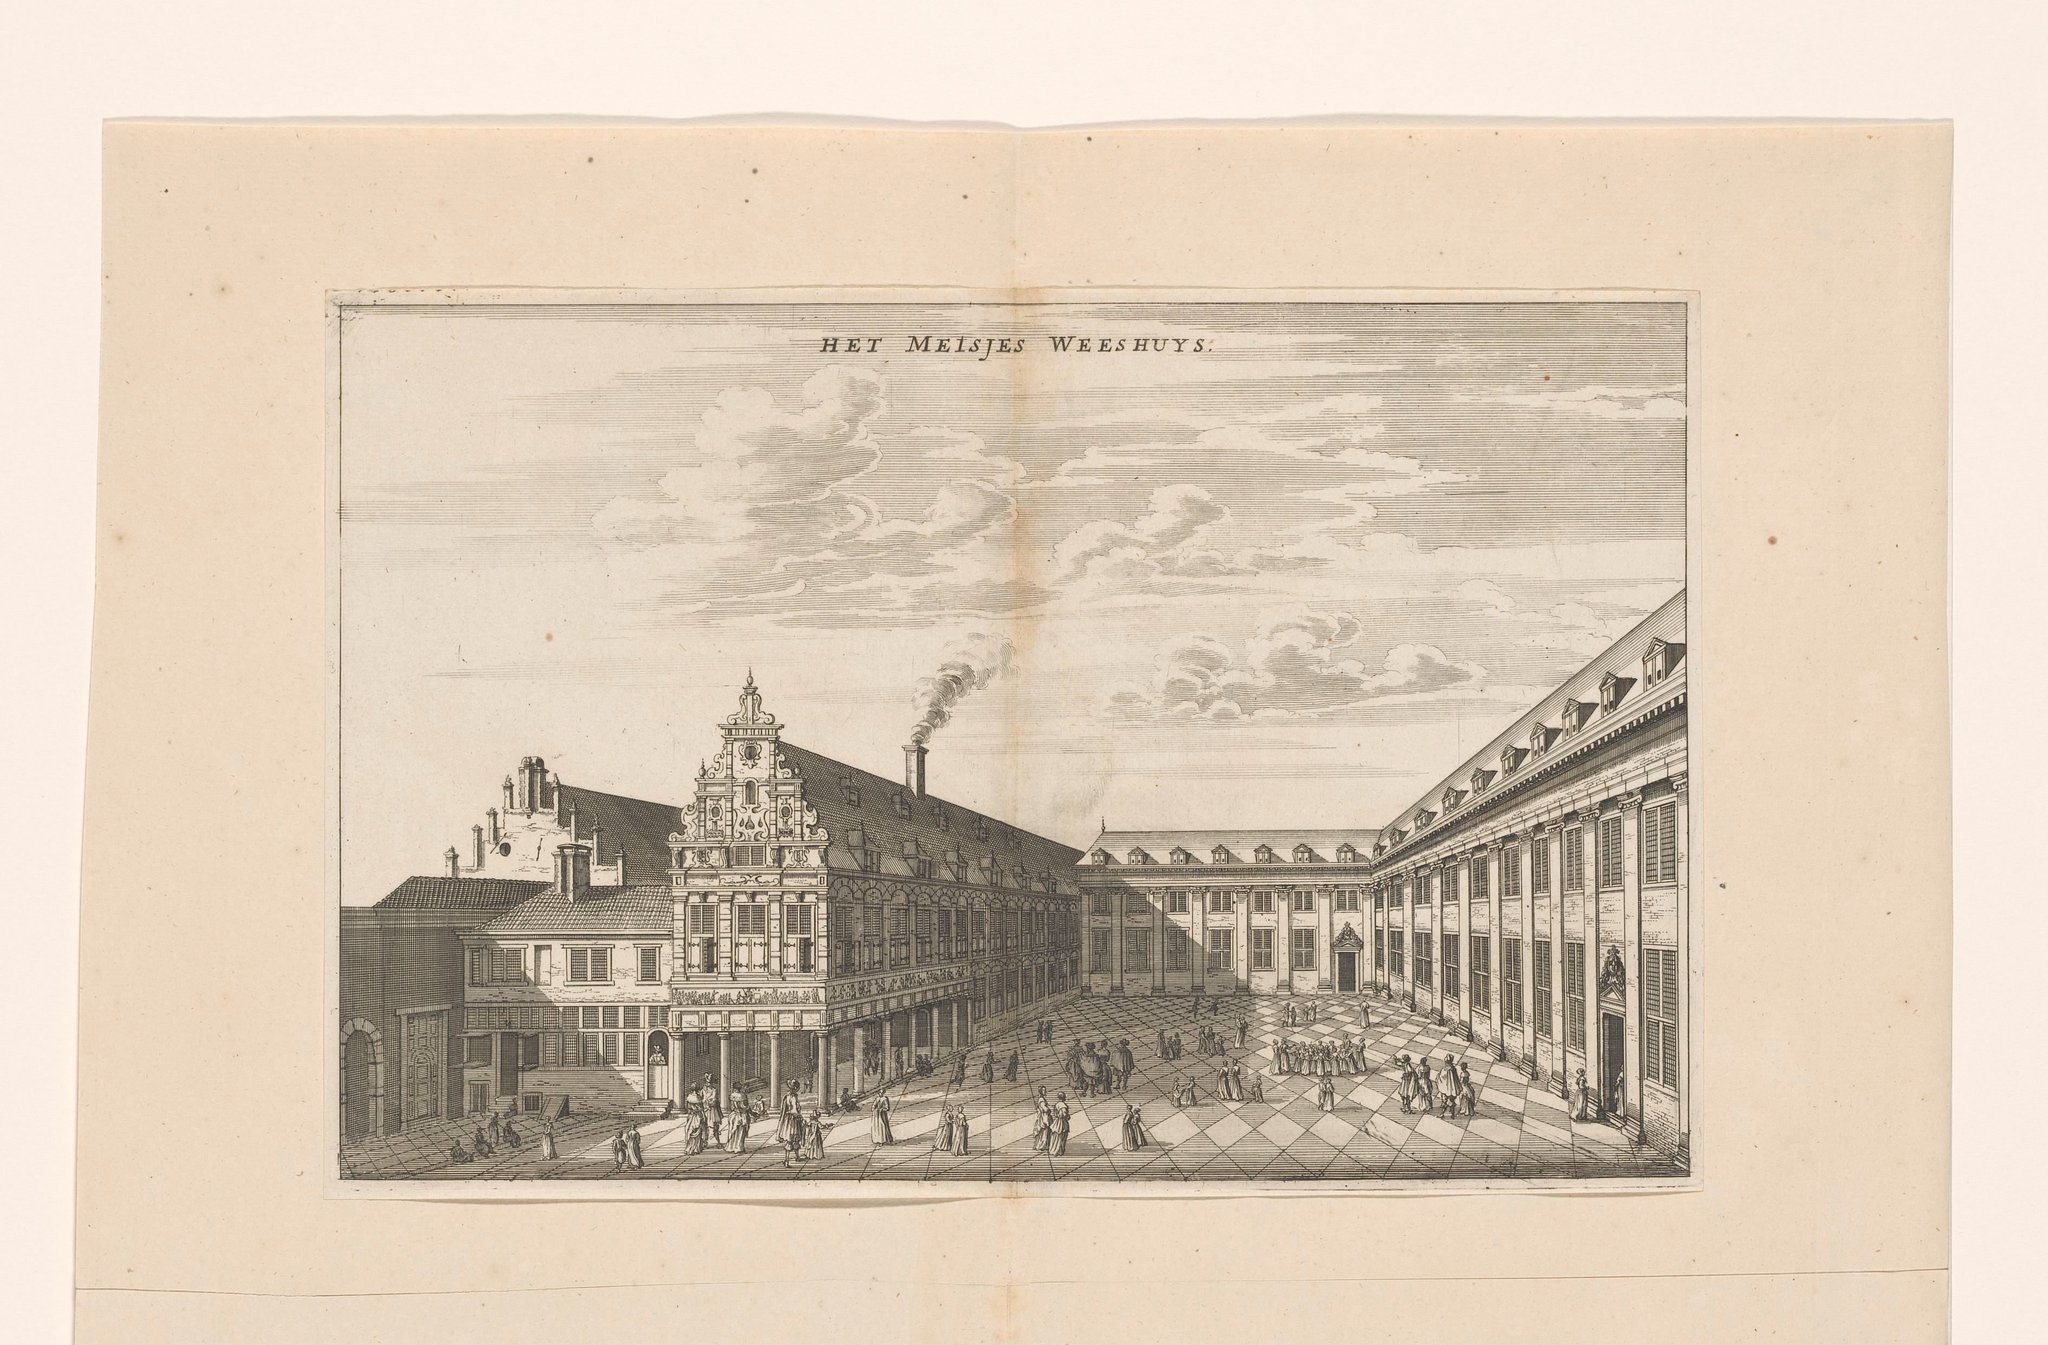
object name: book illustration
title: Het Meisjes Weeshuys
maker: jacob van meurs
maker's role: draughtsman, print maker, publisher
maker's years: 1619-1680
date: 1663-1664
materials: paper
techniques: etching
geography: amsterdam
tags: public welfare, courtyard, orphanage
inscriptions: collector's mark: Lugt 195, collector's mark: Lugt 2228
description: Huidige staat van prent ook gebruikt in: Dapper, Olfert. Historische beschryving der stadt Amsterdam: waer in de voornaemste geschiedenissen (na een kort verhael van gansch Hollant en d'omleggende dorpen (…). Amsterdam: Jacob van Meurs, 1663.* En in: Zesen, Philipp von. Beschreibung der Stadt Amsterdam: darinnen von derselben ersten Ursprunge bis auf gegenwärtigen Zustand (…). Amsterdam: Joachim Nosche, 1664. * In sommige exemplaren van deze uitgave komt de huidige staat van de prent voor. In andere exemplaren is een latere staat ingebonden, waarop boven de Nederlandse een Franse titel is toegevoegd.